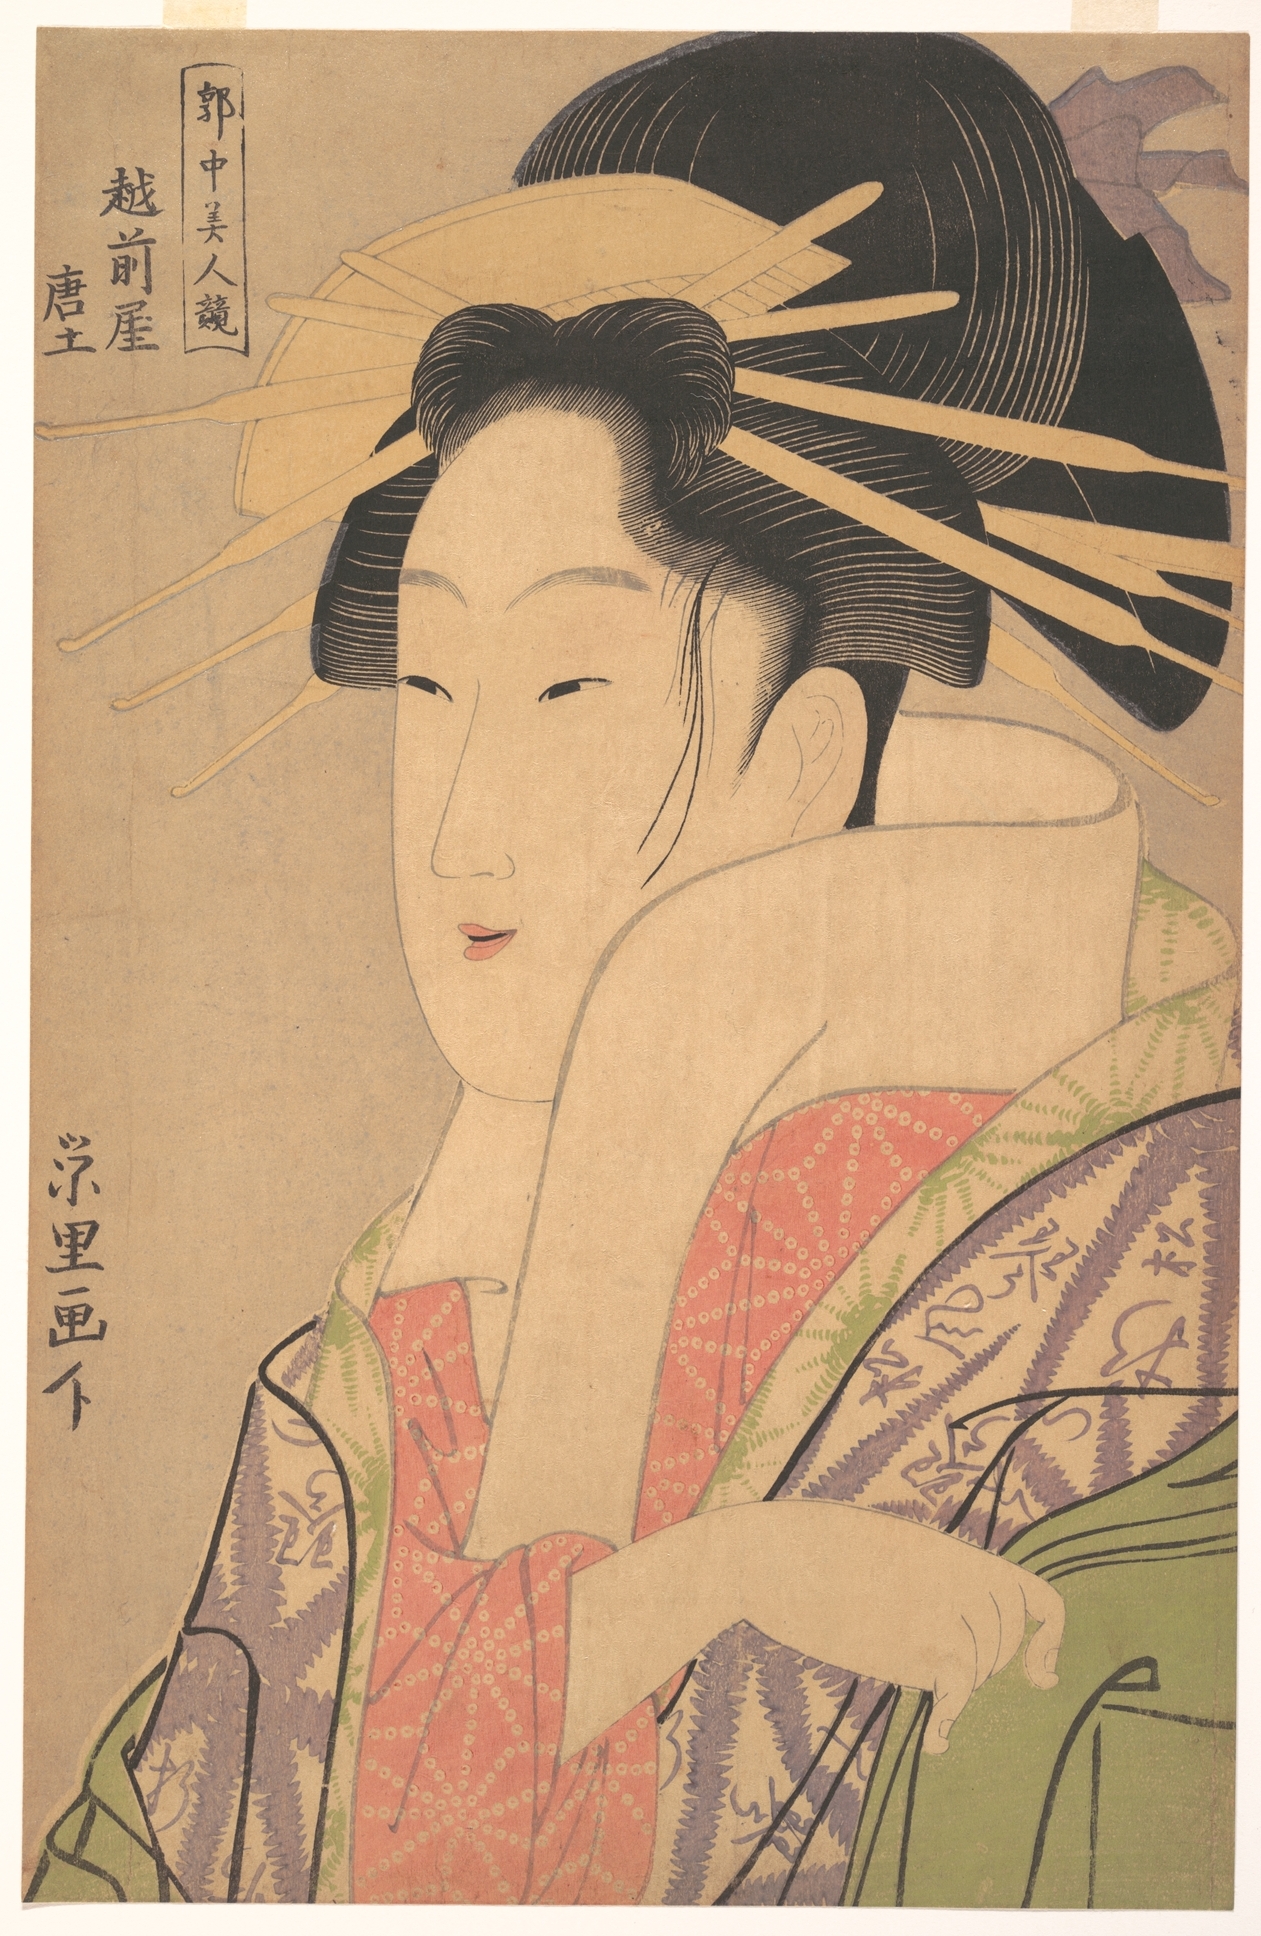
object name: print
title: Karatsuchi of the Echizenya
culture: japanese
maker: chōkyōsai eiri 鳥橋斎栄里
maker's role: artist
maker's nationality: japanese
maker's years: 1789-1801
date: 1795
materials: ink, paper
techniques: woodblock print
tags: women